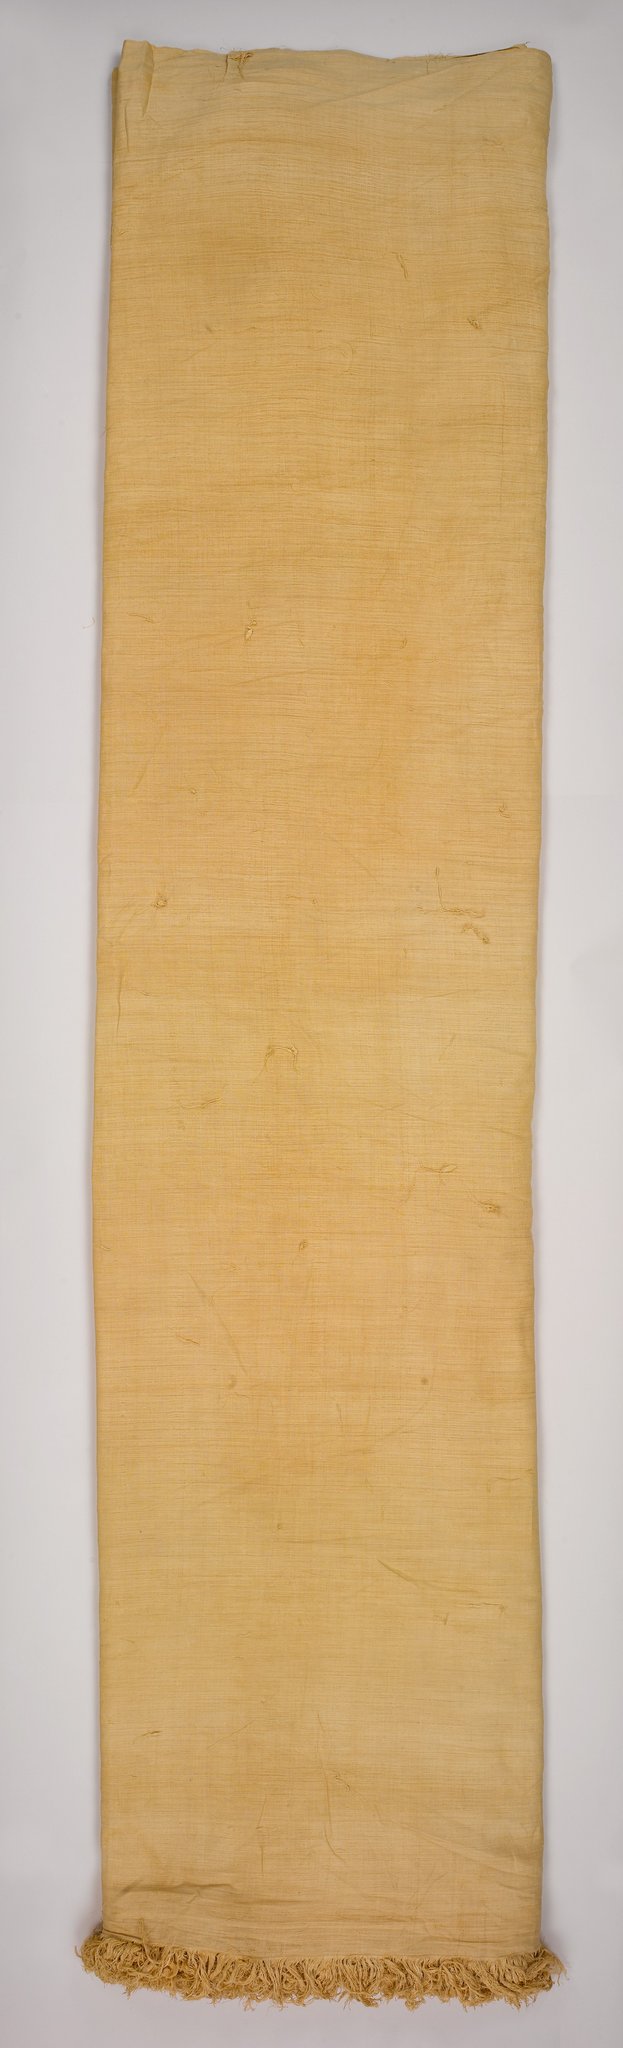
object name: sheet, mattress, tufted, weaver's mark preserved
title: Sheet Folded into a Mattress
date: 1981-1975 BCE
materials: linen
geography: egypt